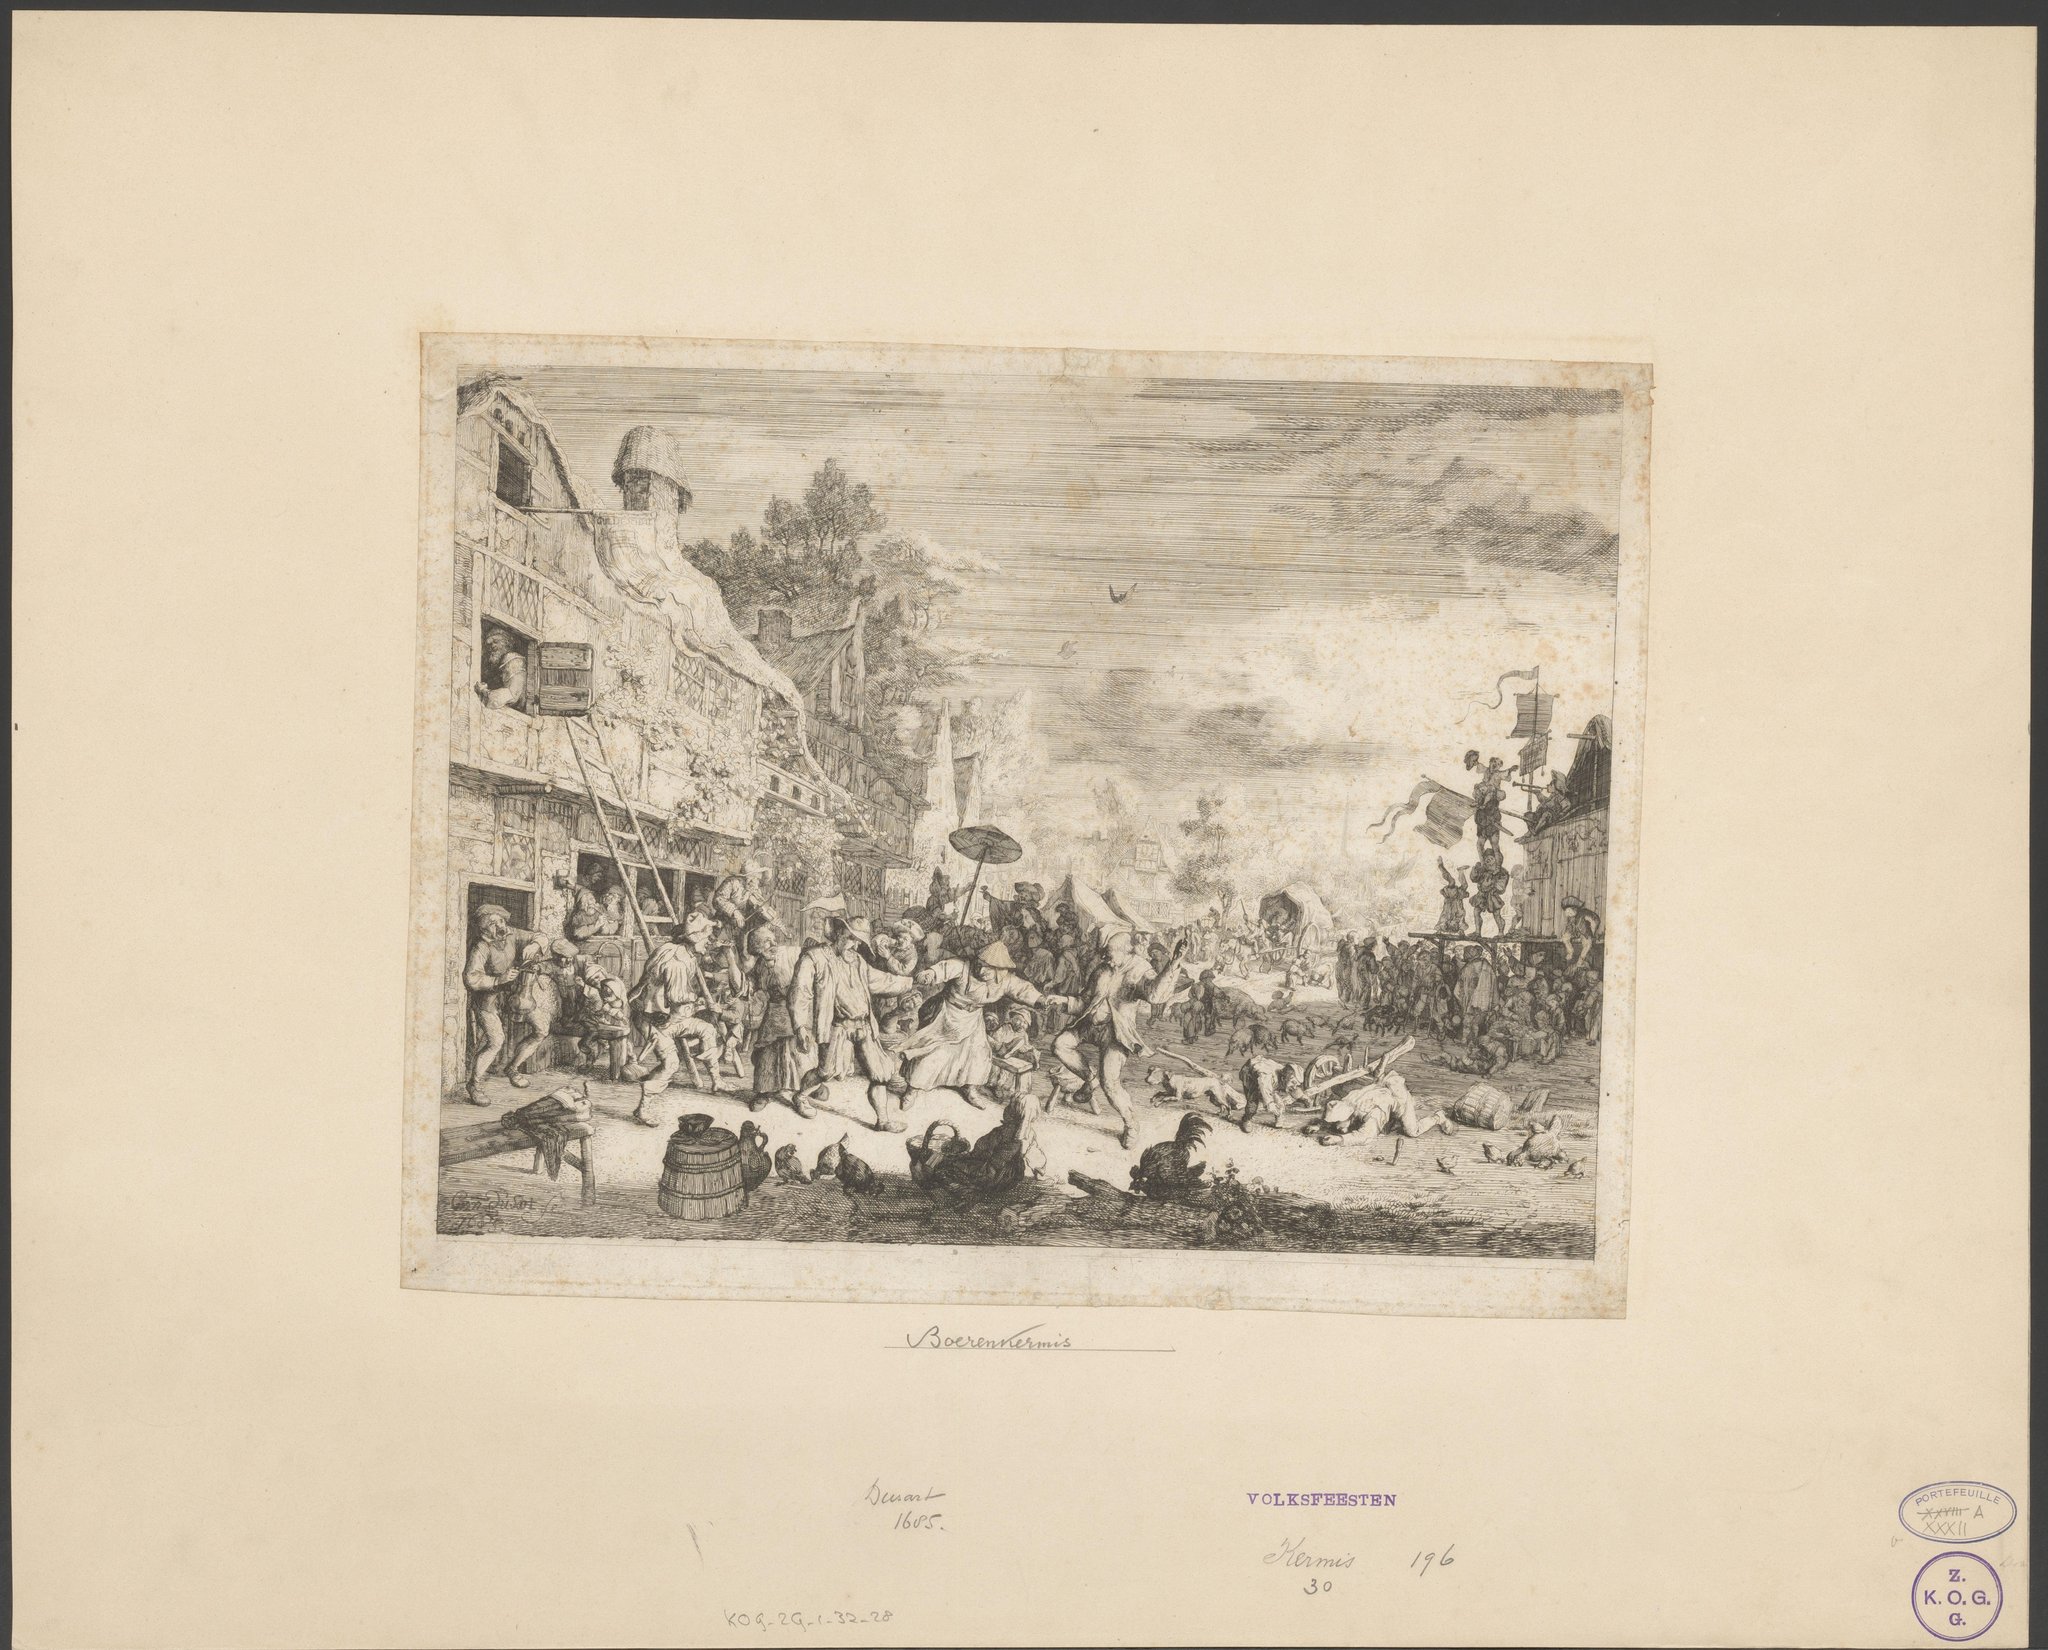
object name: print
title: Grote dorpskermis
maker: cornelis dusart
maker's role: draughtsman, painter, print maker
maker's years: 1660-1704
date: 1685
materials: paper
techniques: engraving, etching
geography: netherlands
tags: folk dancing (men and women together), acrobat ~ circus, performance in the open air (pleasure fair), pavement, terrace in front of inn or restaurant, alcoholic drinks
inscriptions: collector's mark, collector's mark: Lugt 1641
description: Grote dorpskermis. In een dorpsstraat wordt gedanst en muziek gemaakt voor een herberg waar de drank rijkelijk vloeit. Acrobaten vertonen hun kunsten op een podium en varkens en kippen scharrelen op zoek naar voedsel tussen de feestende dorpsbewoners. Onderwerpsrubrieken binnen de Atlas Zeden en Gewoonten: Volksfeesten; Kermis.